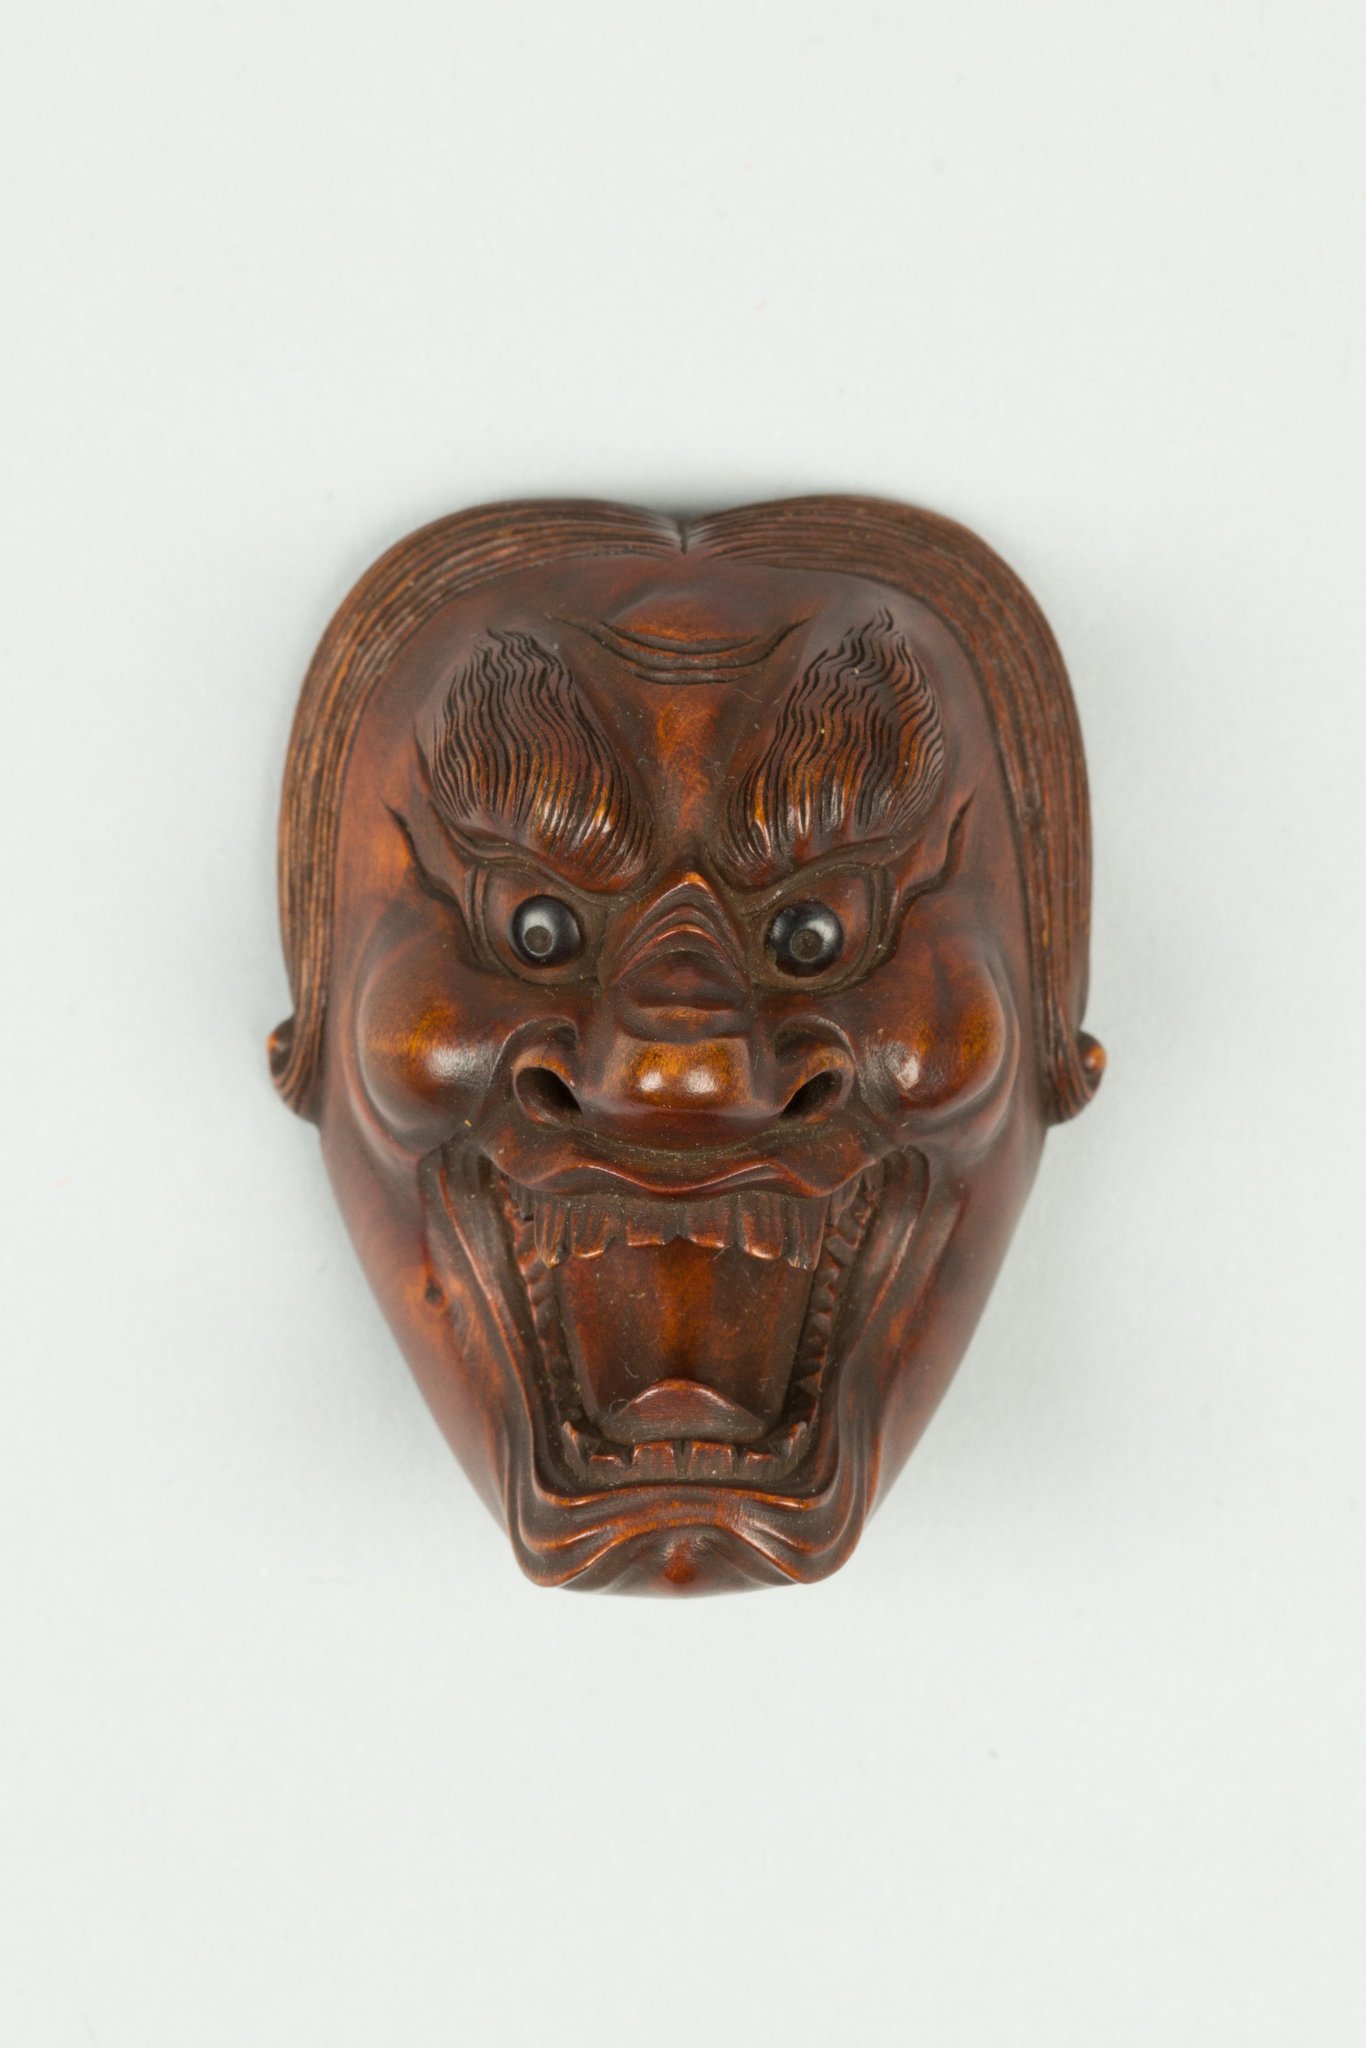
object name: netsuke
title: Netsuke of Mask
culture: japanese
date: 1801-1900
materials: wood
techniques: inlay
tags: masks